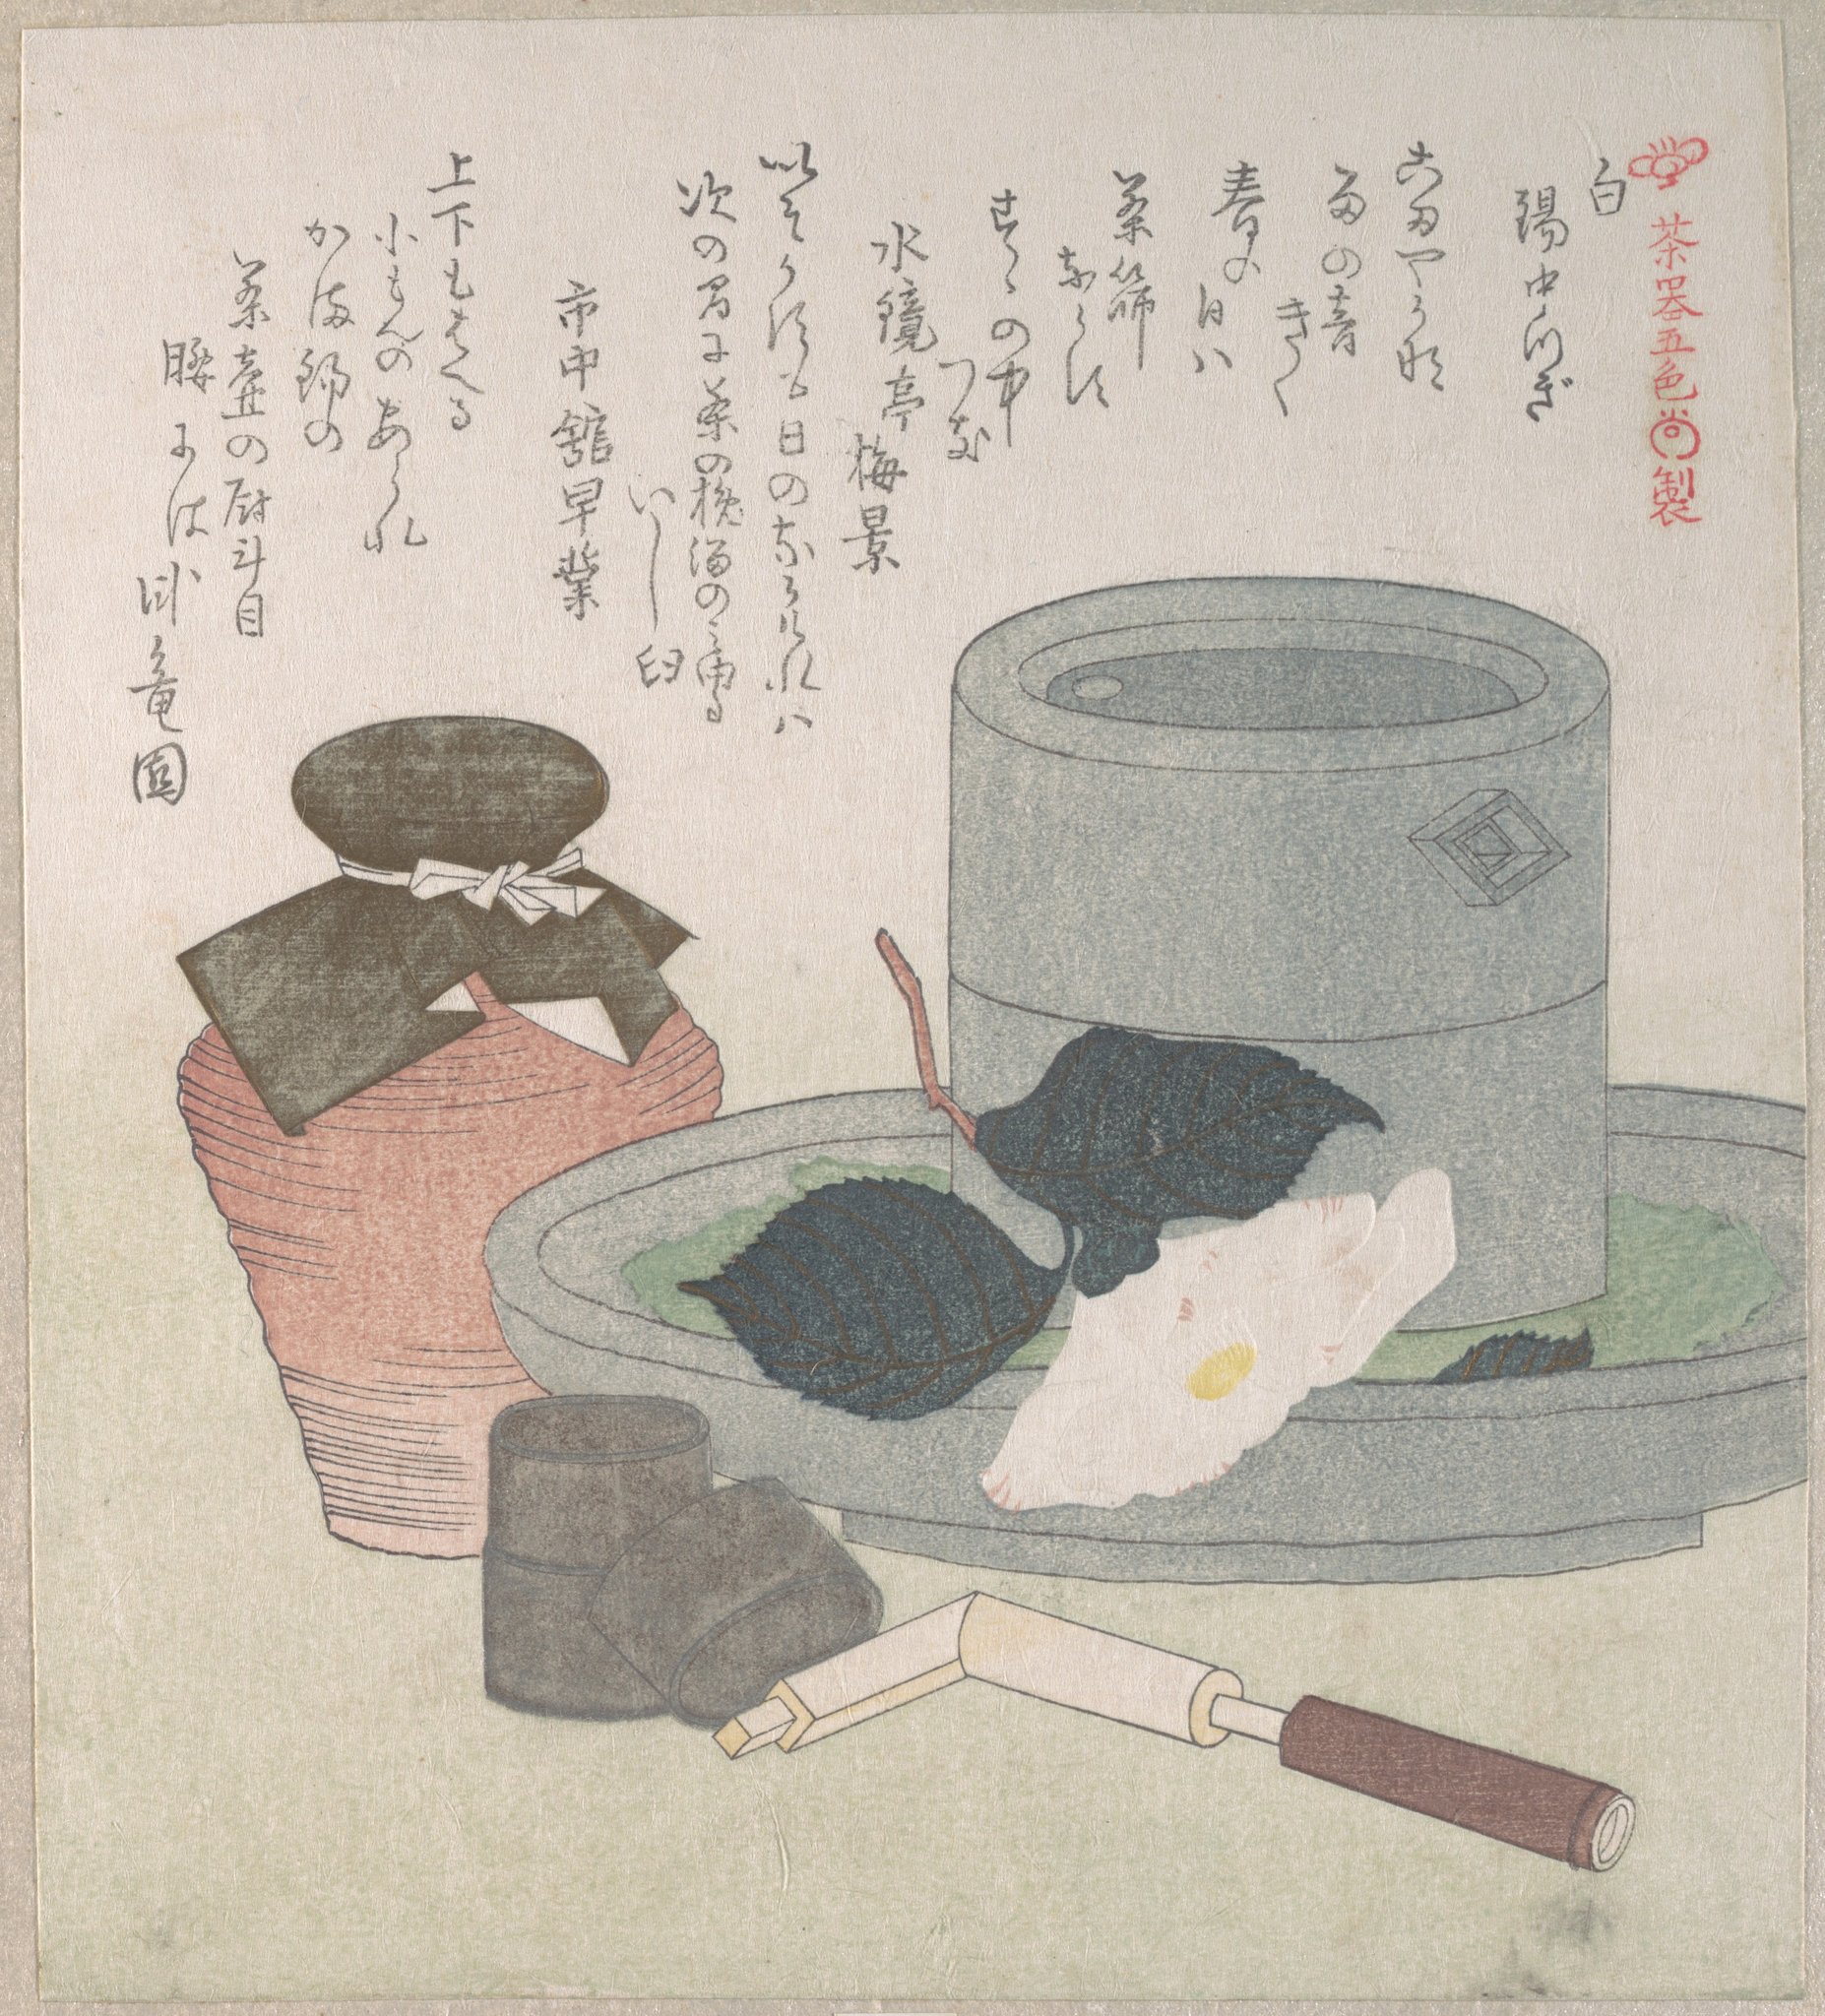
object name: print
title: White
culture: japanese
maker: kubo shunman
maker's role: artist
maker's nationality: japanese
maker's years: 1757-1820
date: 1801-1900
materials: ink, paper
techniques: surimono, woodblock print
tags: flowers,tea ceremony